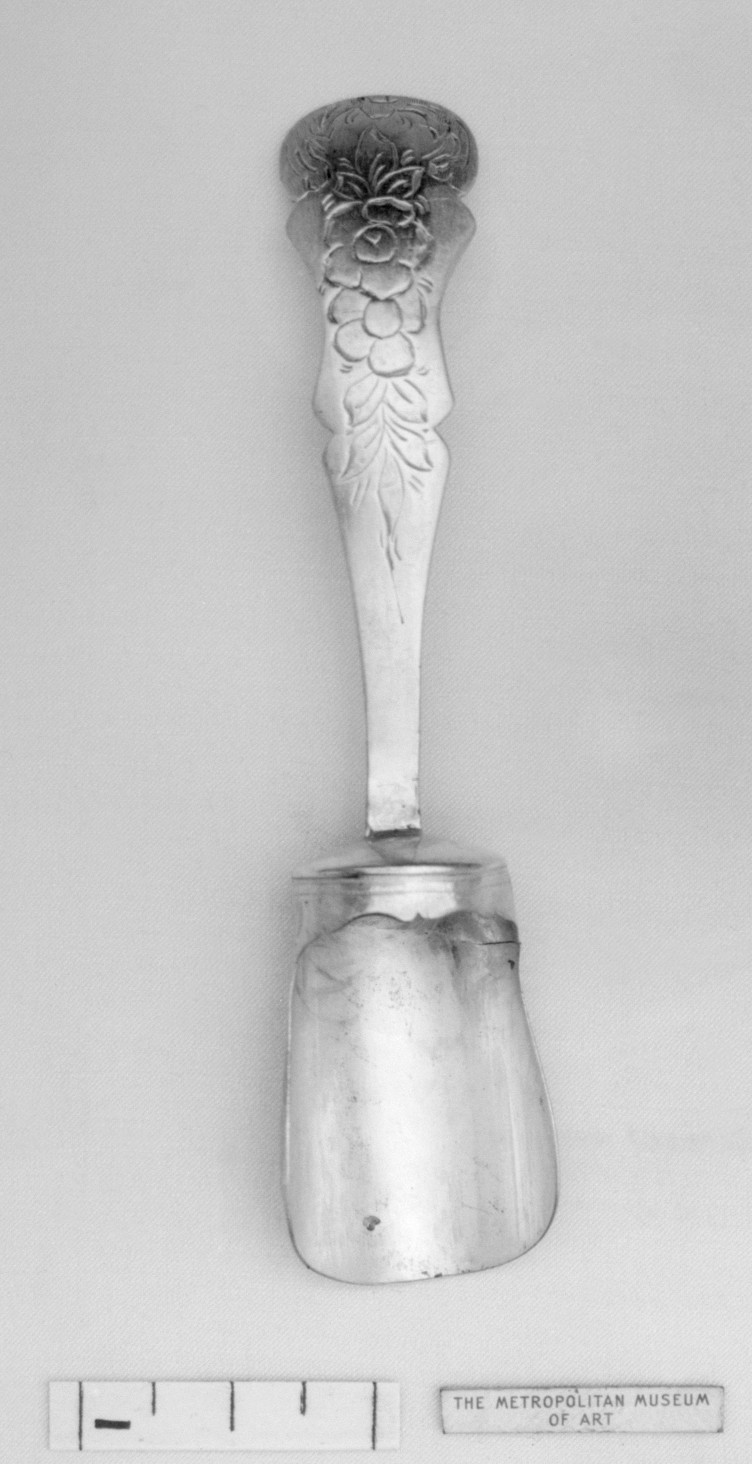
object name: caddy spoon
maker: andreas schiotteling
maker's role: maker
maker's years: 1750-1850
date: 1809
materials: silver